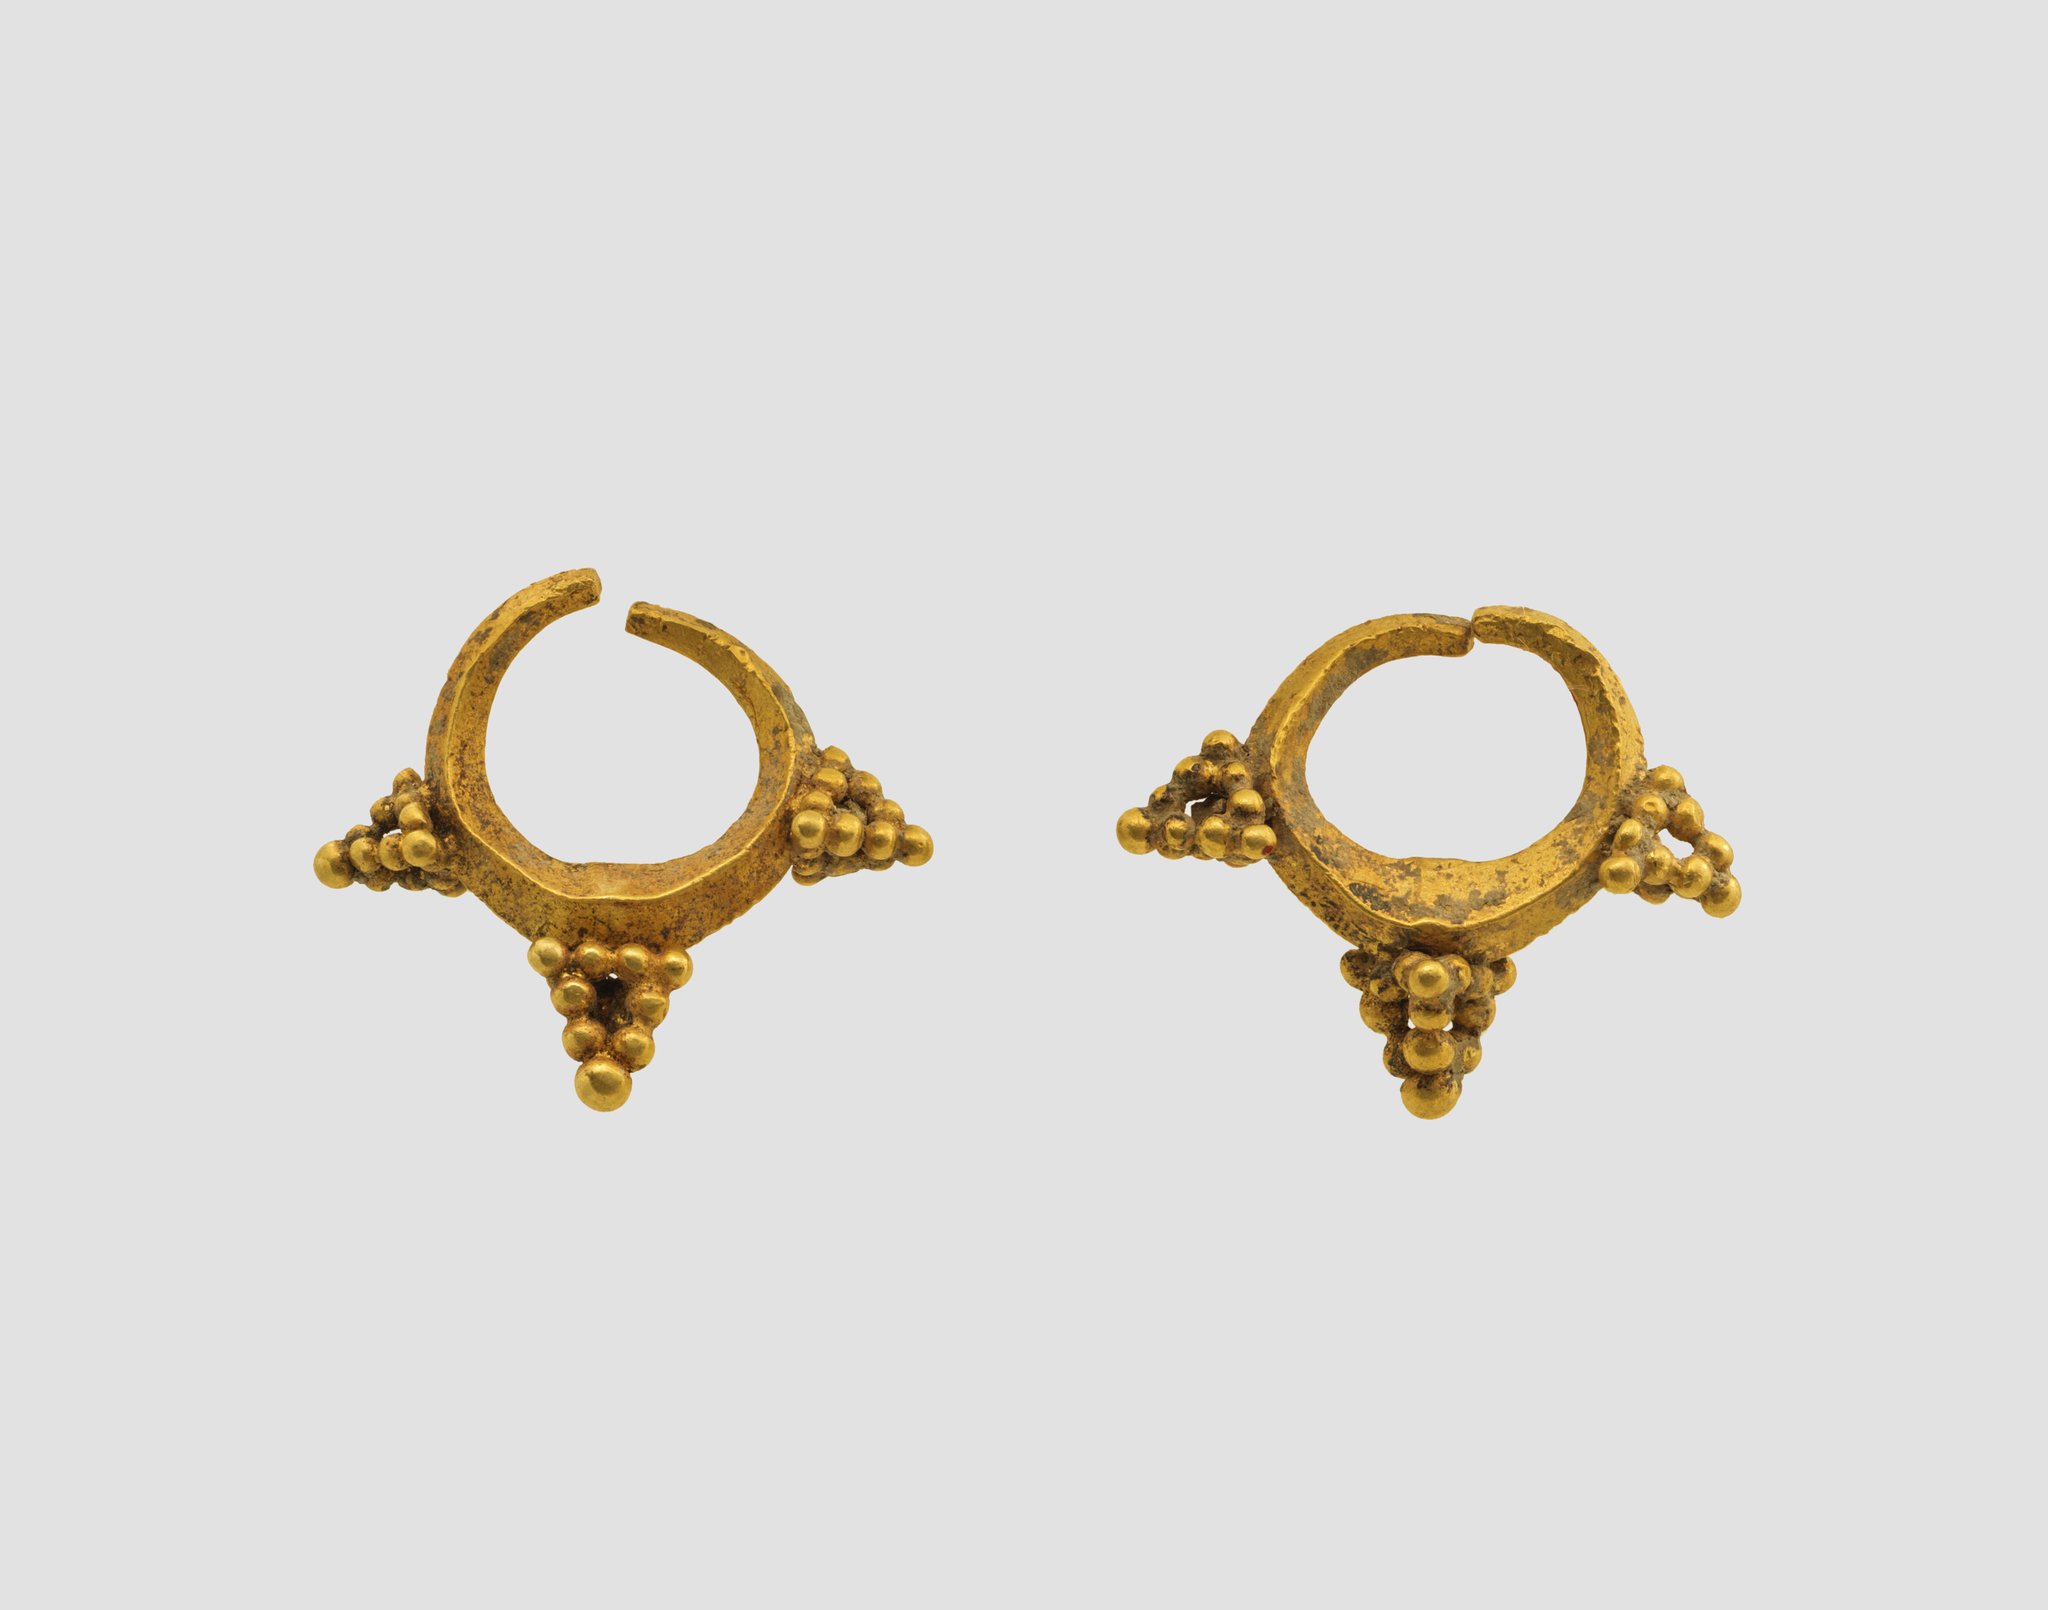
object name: earring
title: Earrings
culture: iranian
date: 2000-1 BCE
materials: gold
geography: iran